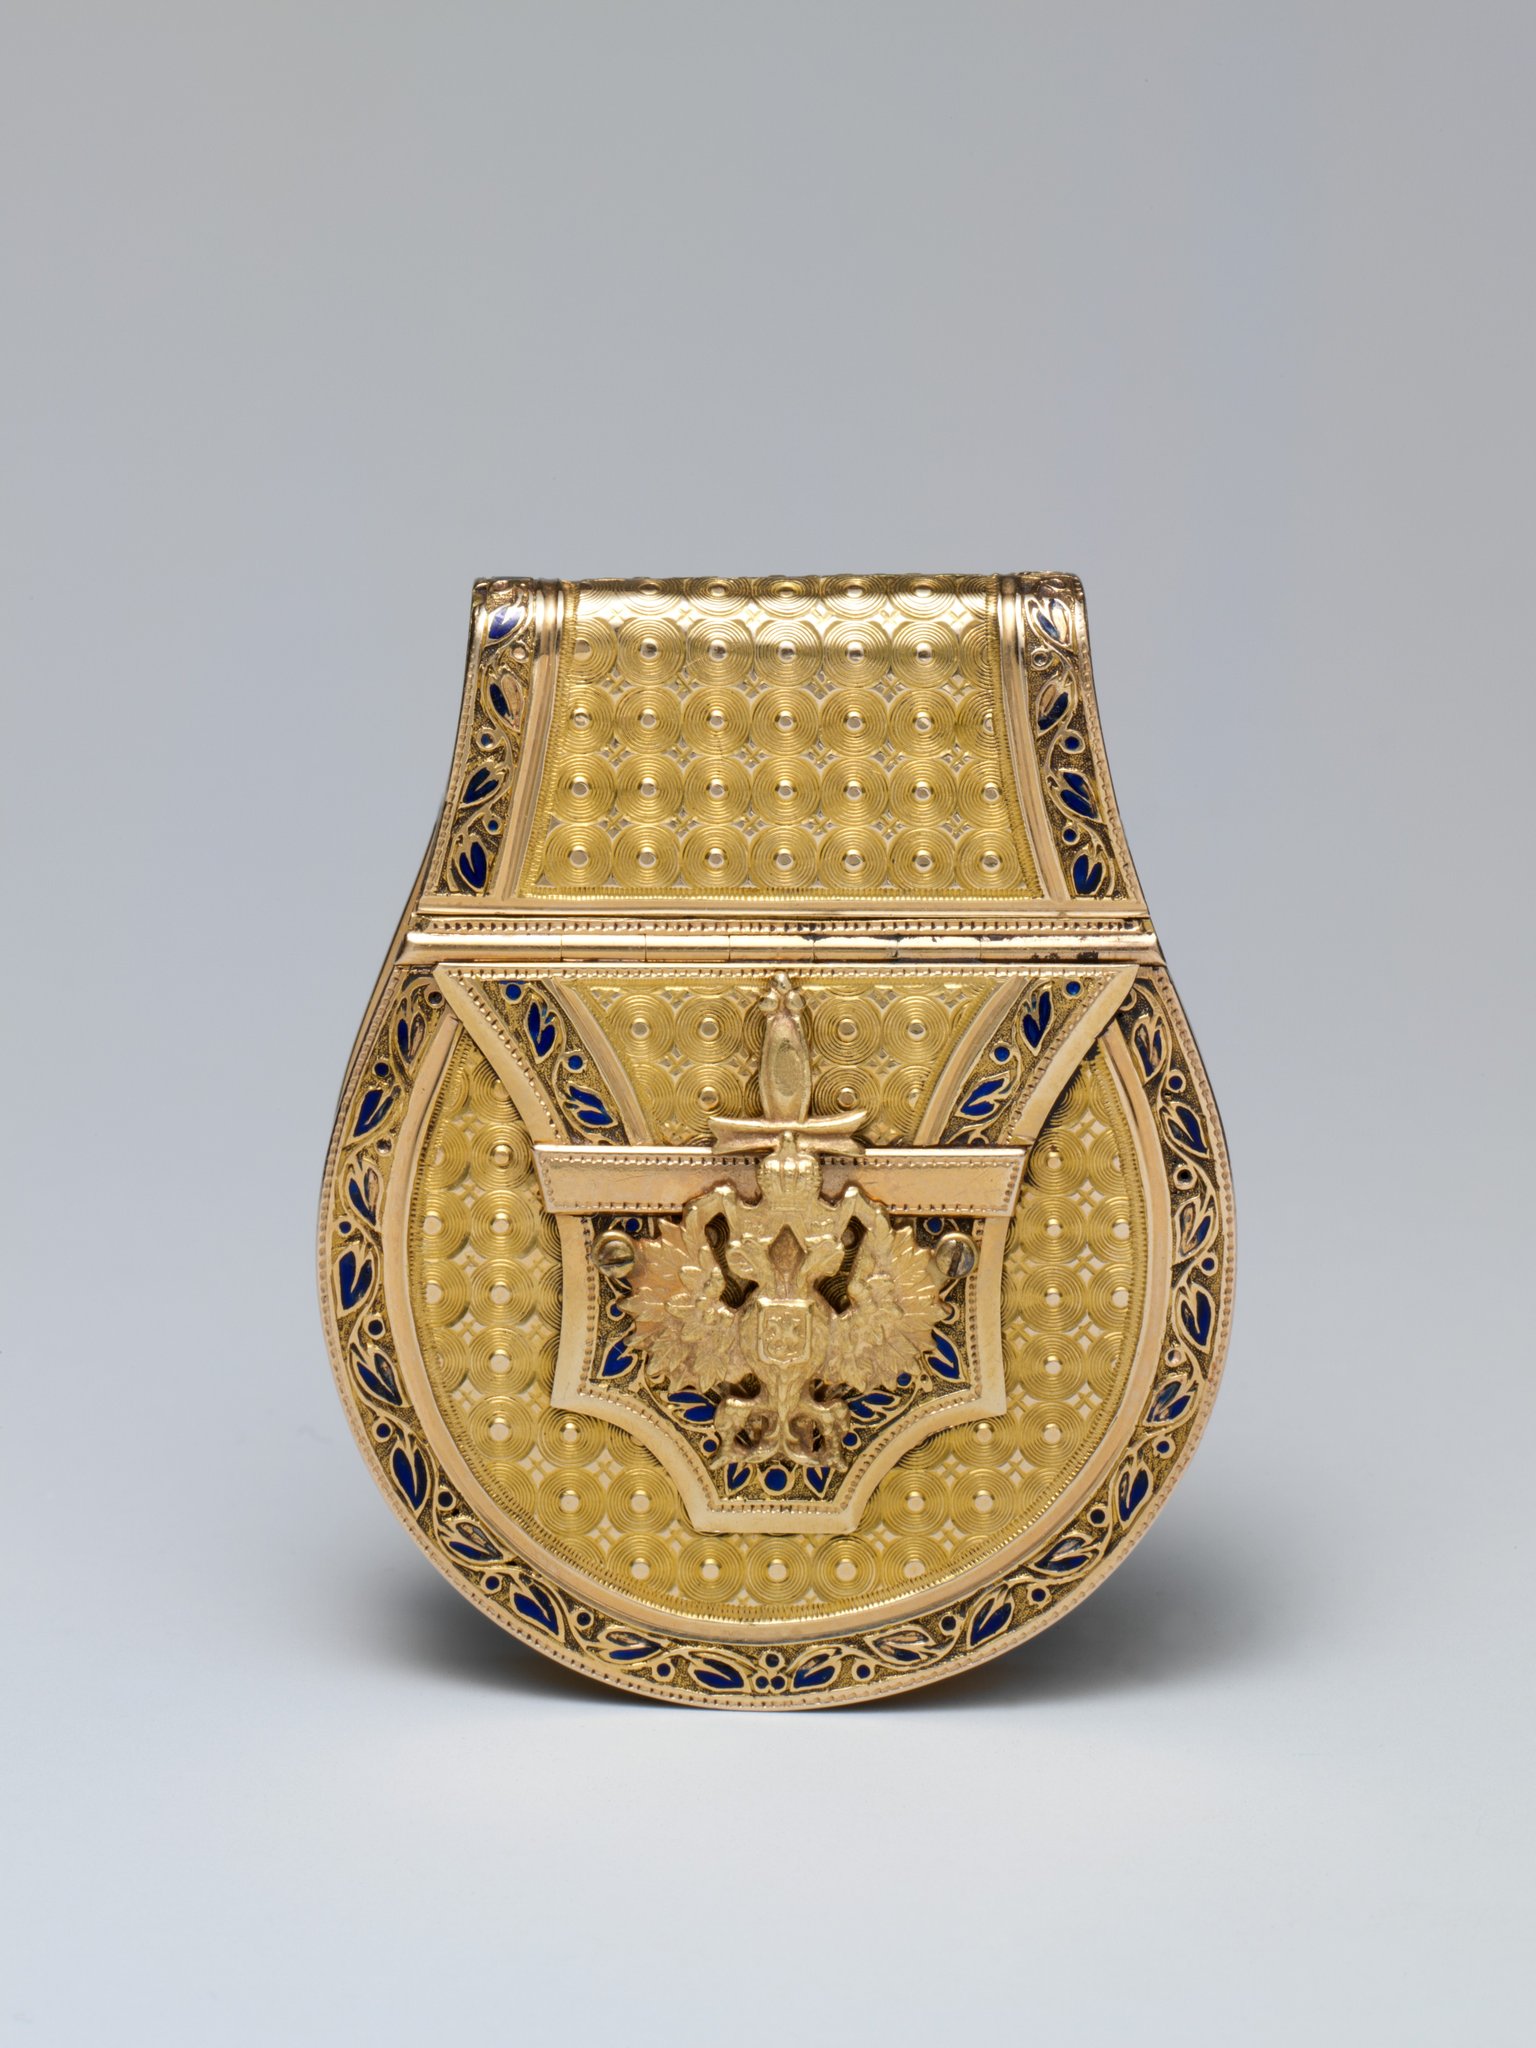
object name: music box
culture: swiss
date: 1810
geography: switzerland